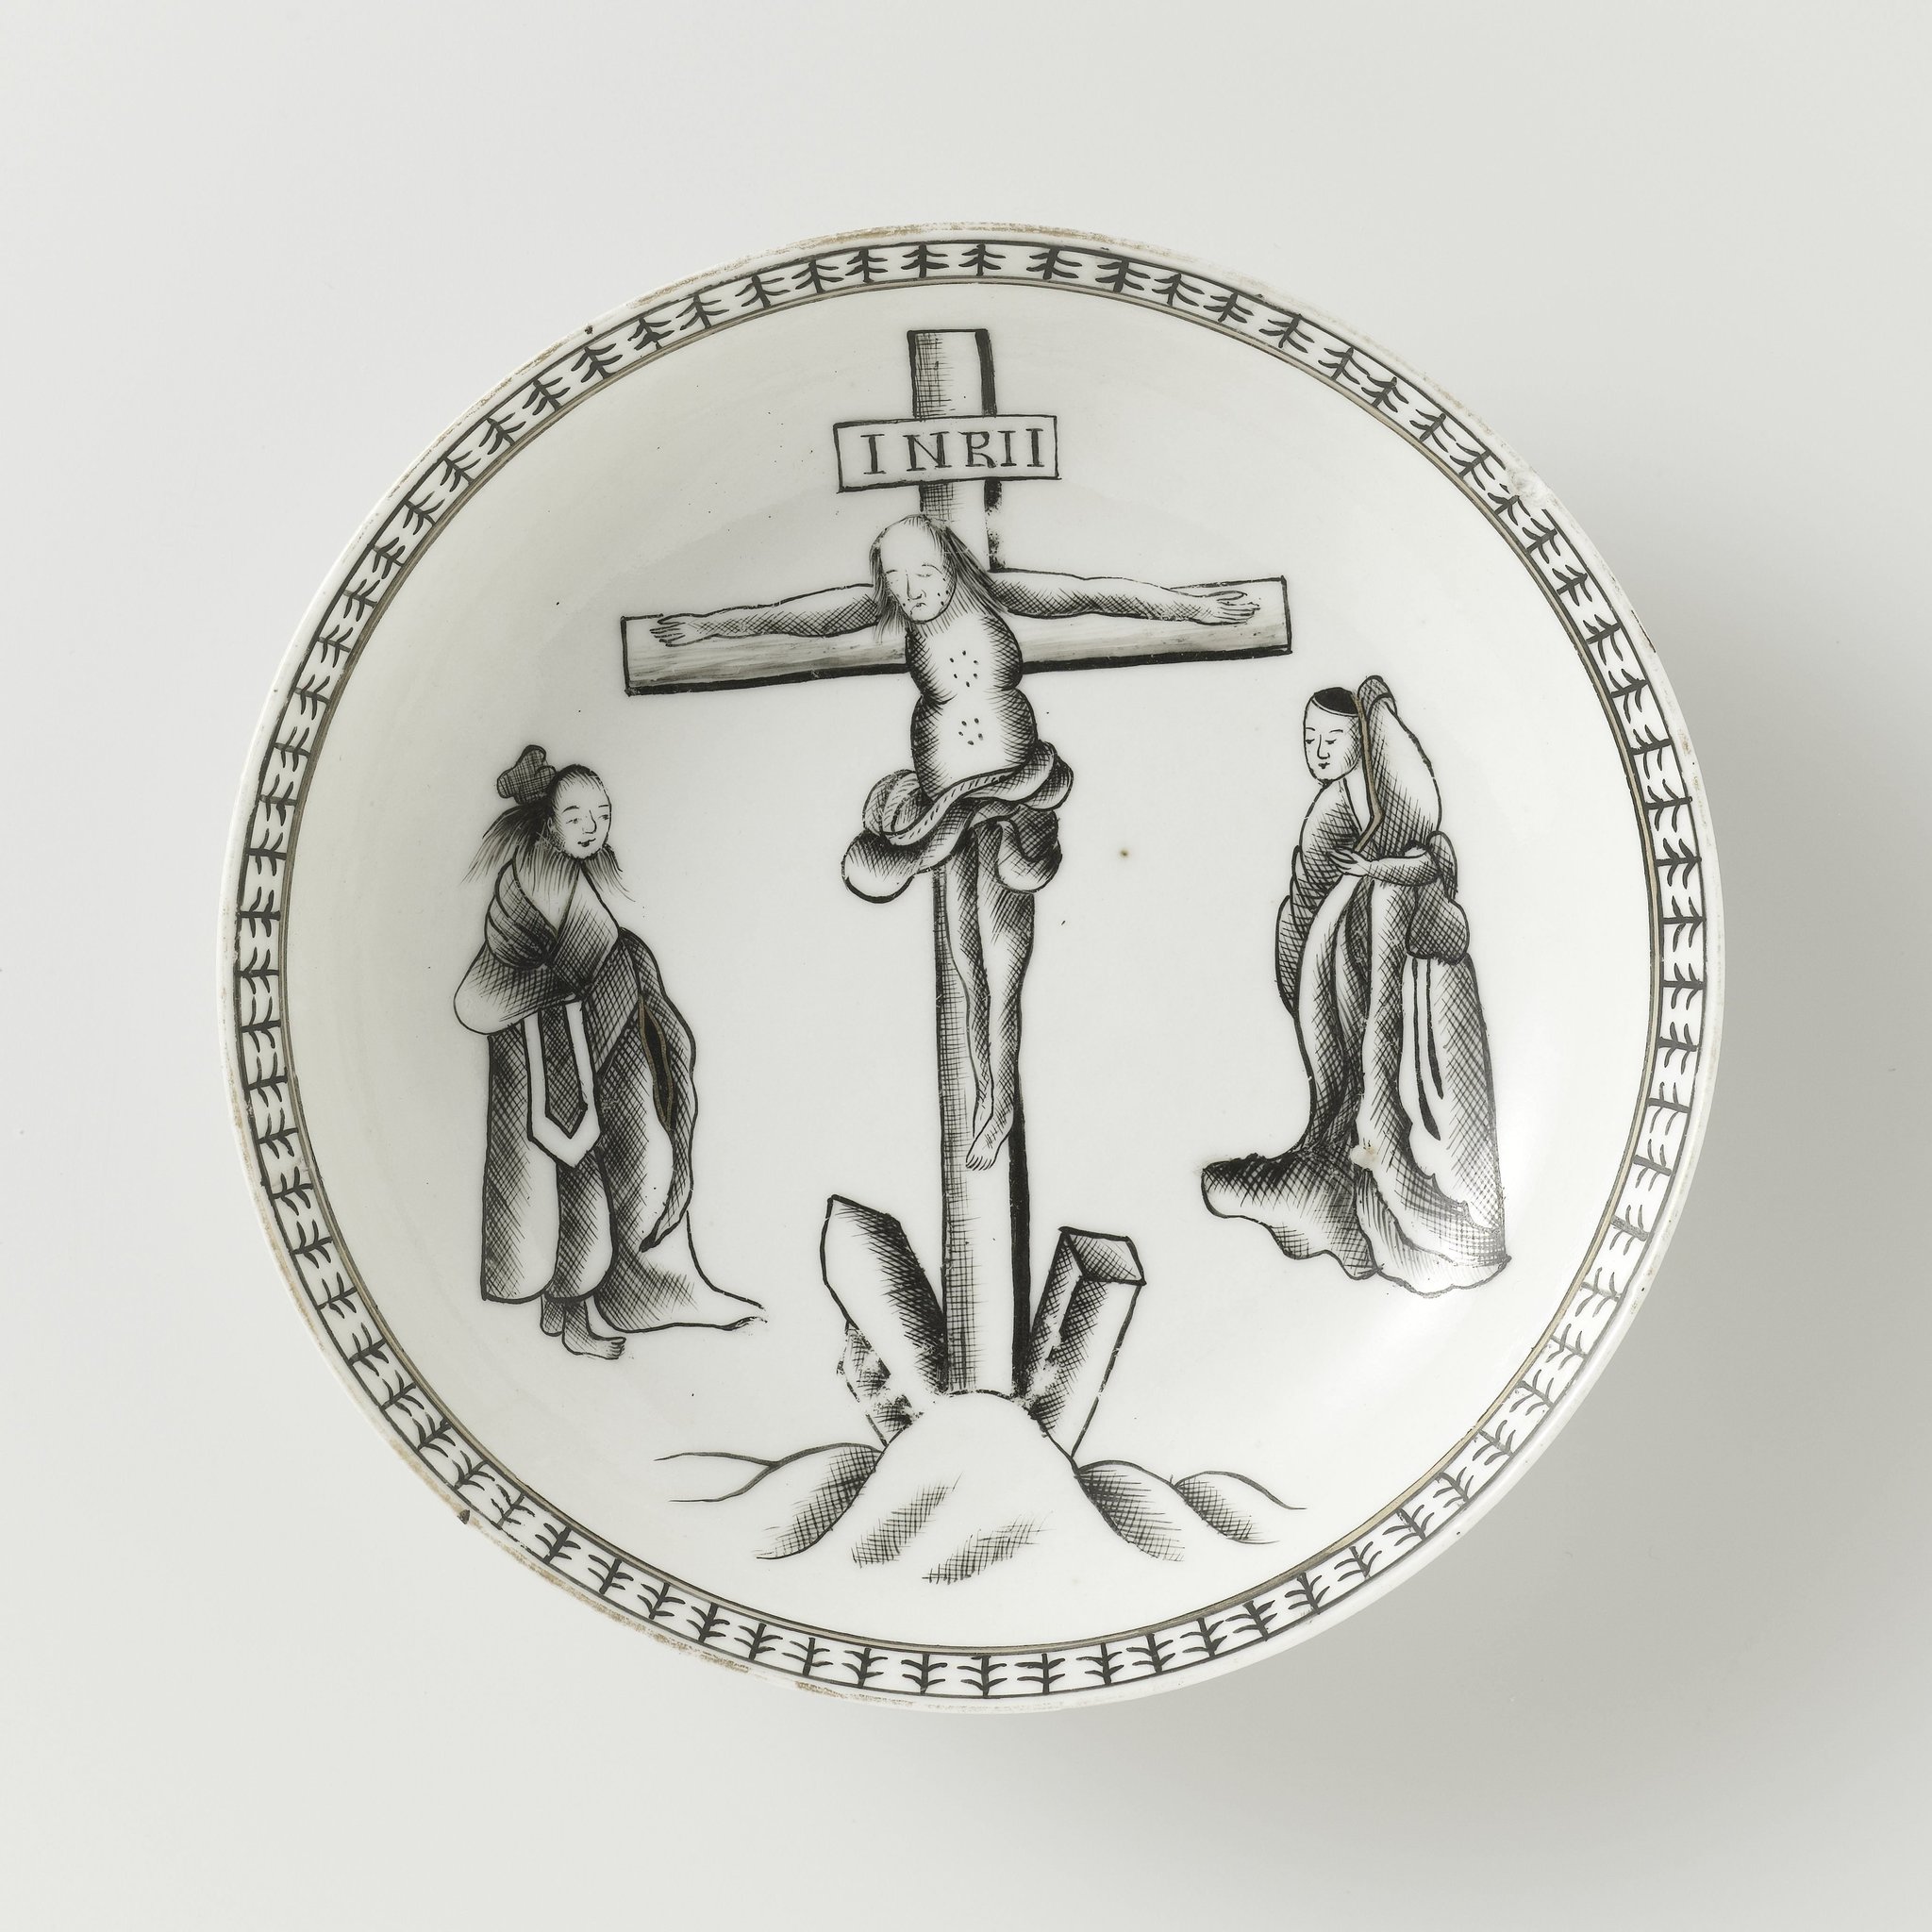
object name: platter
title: Saucer with a crucifixion scene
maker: Anonymous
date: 1780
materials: glaze, gold, paint, porcelain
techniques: firing, gilding, turning, vitrification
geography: china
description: Schotel van porselein, beschilderd op het glazuur in zwart en goud. Op het plat van de schotel een voorstelling van de Kruisiging met de twee Maria's; op de rand een band met een decoratief patroon. Twee barsten en een chip in de rand. Onderdeel van een theeservies. Europese voorstelling in encre de Chine.